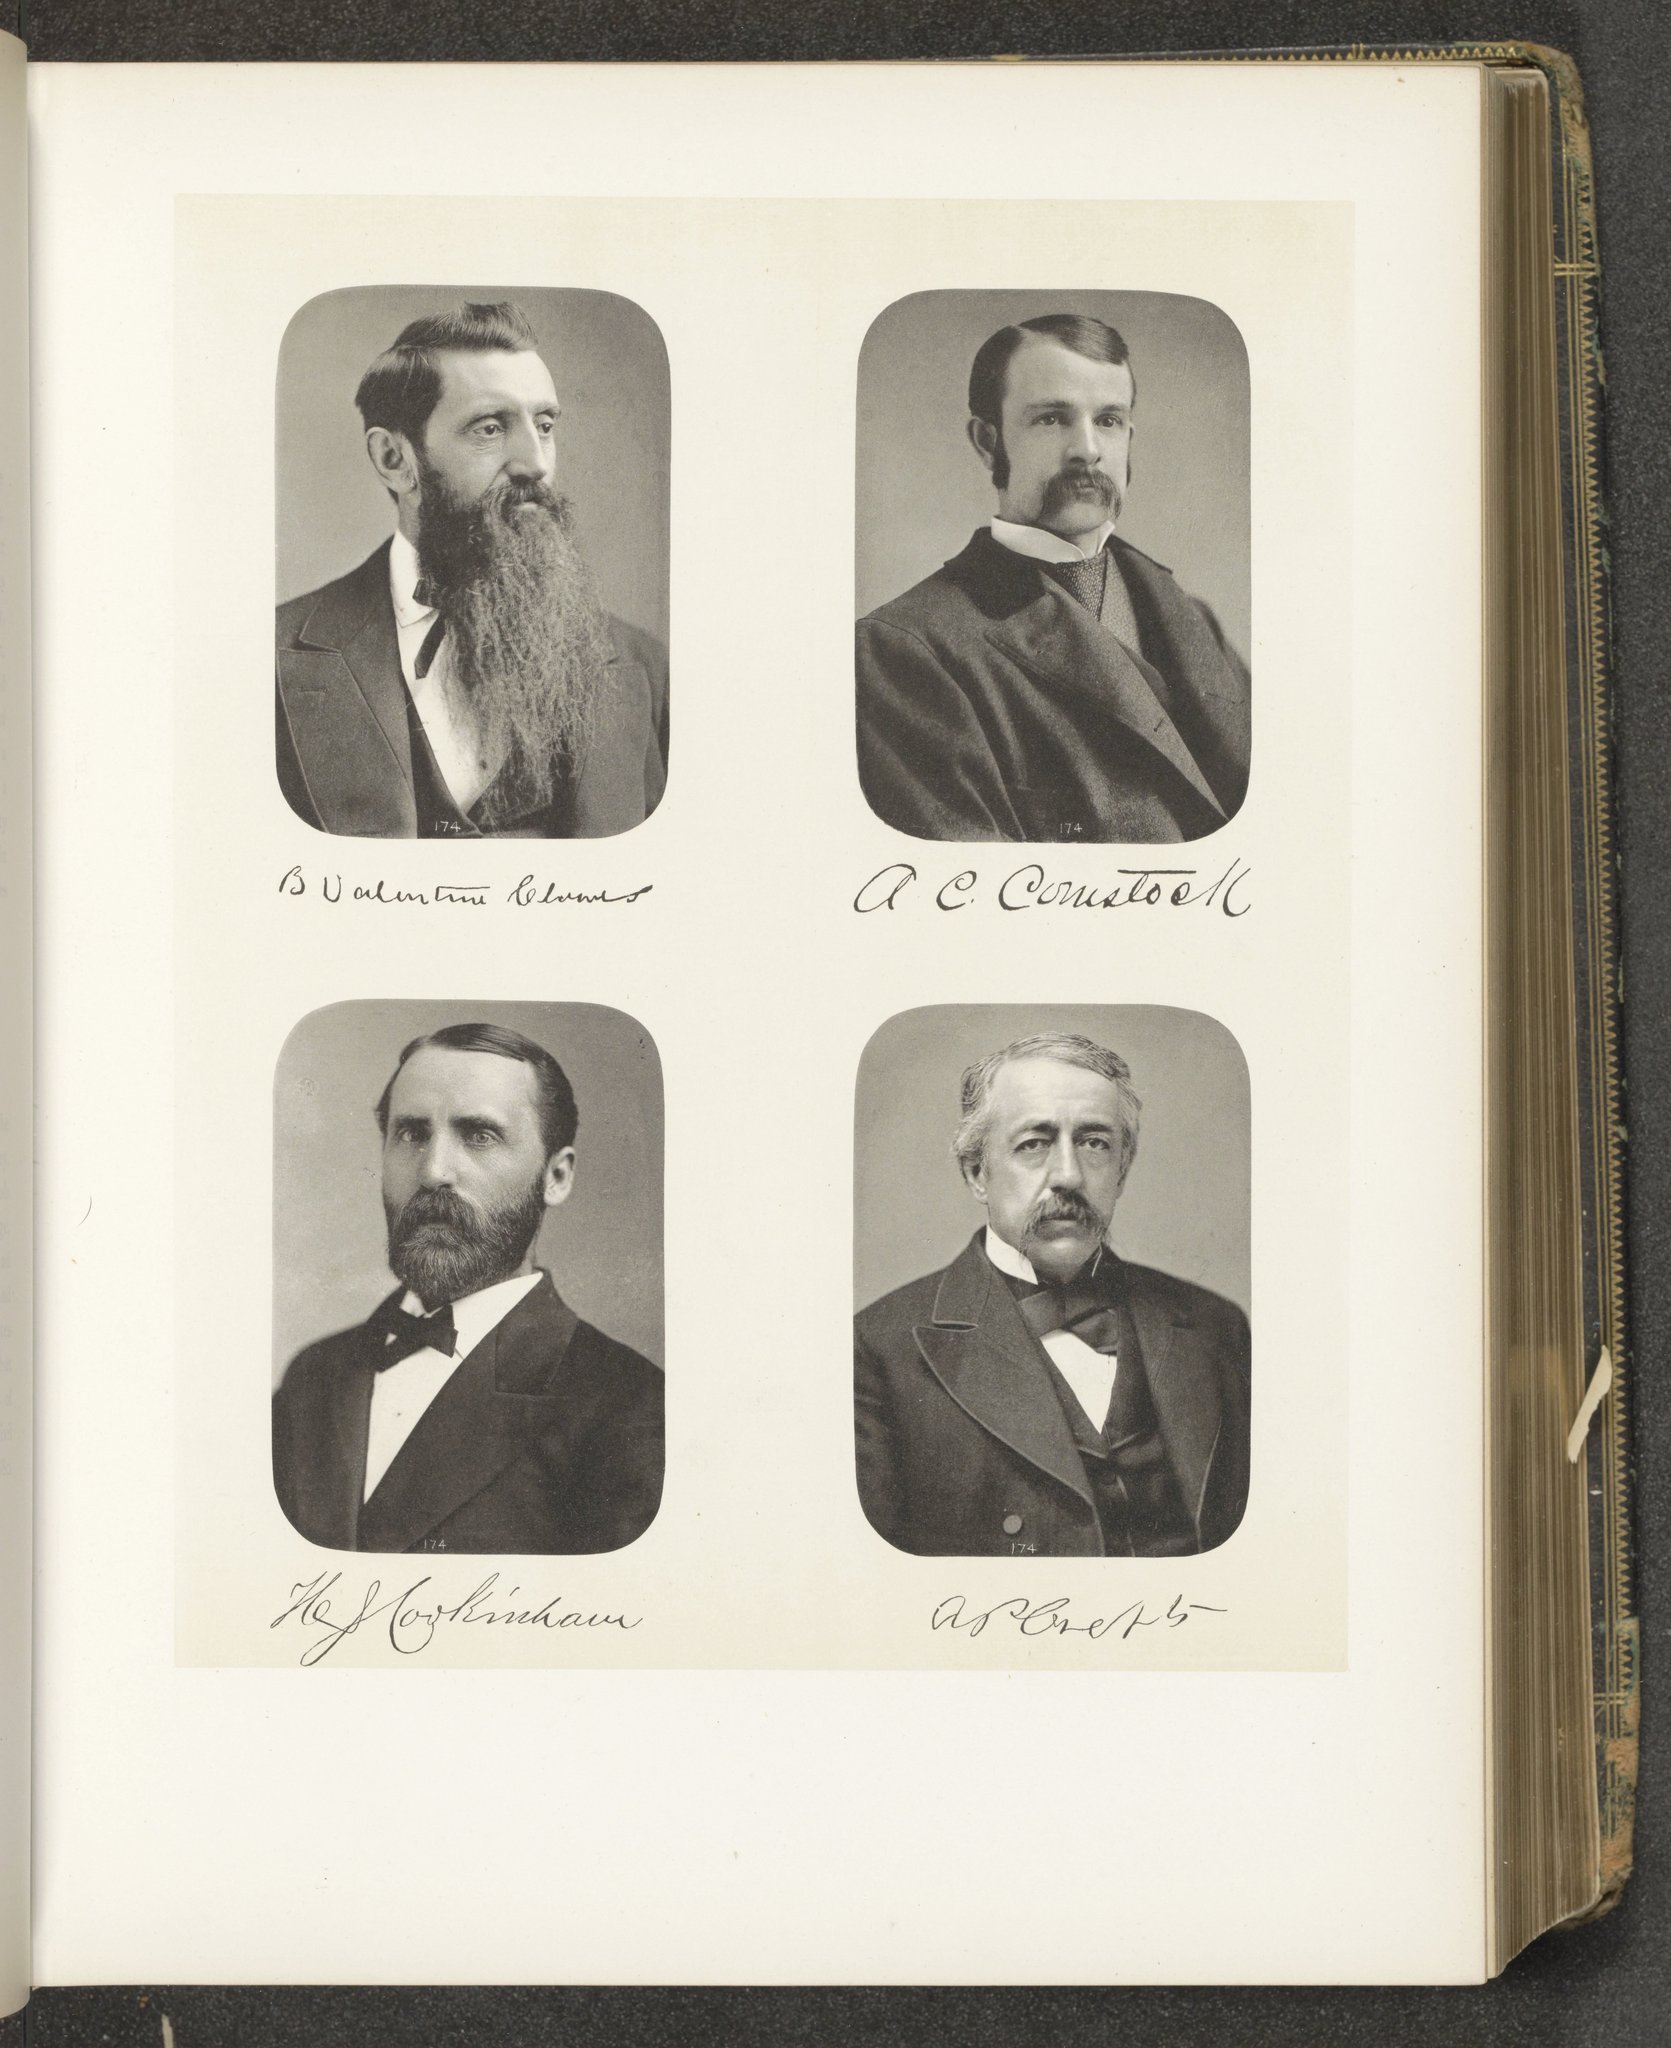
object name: page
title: Portretten van vier leden van het Lagerhuis van de staat New York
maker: Anonymous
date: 1872-1882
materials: paper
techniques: photograph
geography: united states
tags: historical persons (portraits and scenes from the life) (+ head (and shoulders) (portrait))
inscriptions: number: ‘174’, annotation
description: Linksboven B. Valentine Clowes, rechtsboven Albert C. Comstock, linksonder Henry J. Cookinham, rechtsonder Alfred P. Crafts.